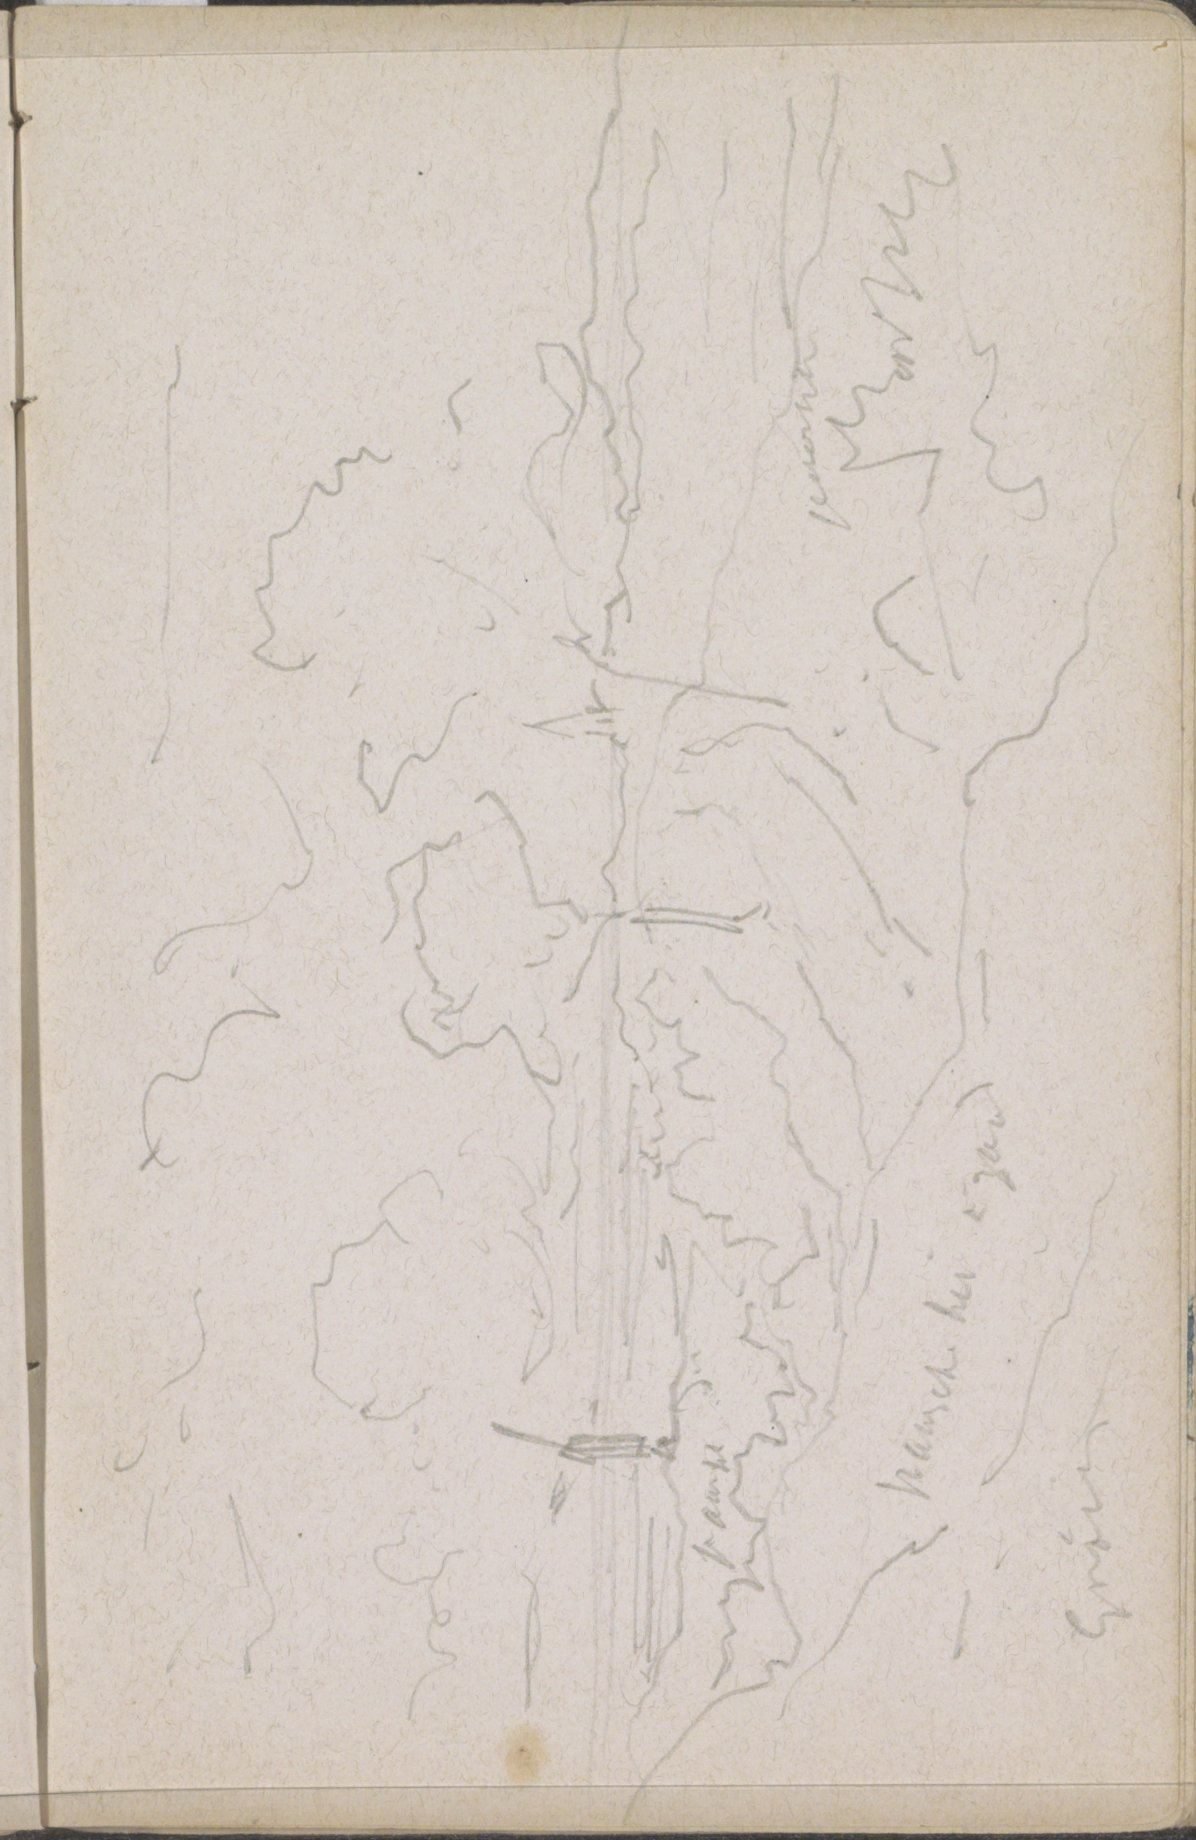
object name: sketchbook leaf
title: Heuvellandschap met bomen en een molen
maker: johannes tavenraat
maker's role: draughtsman, painter, print maker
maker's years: 1809-1881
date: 1862-1864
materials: paper, pencil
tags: low hill country, trees, windmill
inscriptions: kleurnotitie, handgeschreven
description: Blad 43 recto uit een schetsboek met 65 bladen.